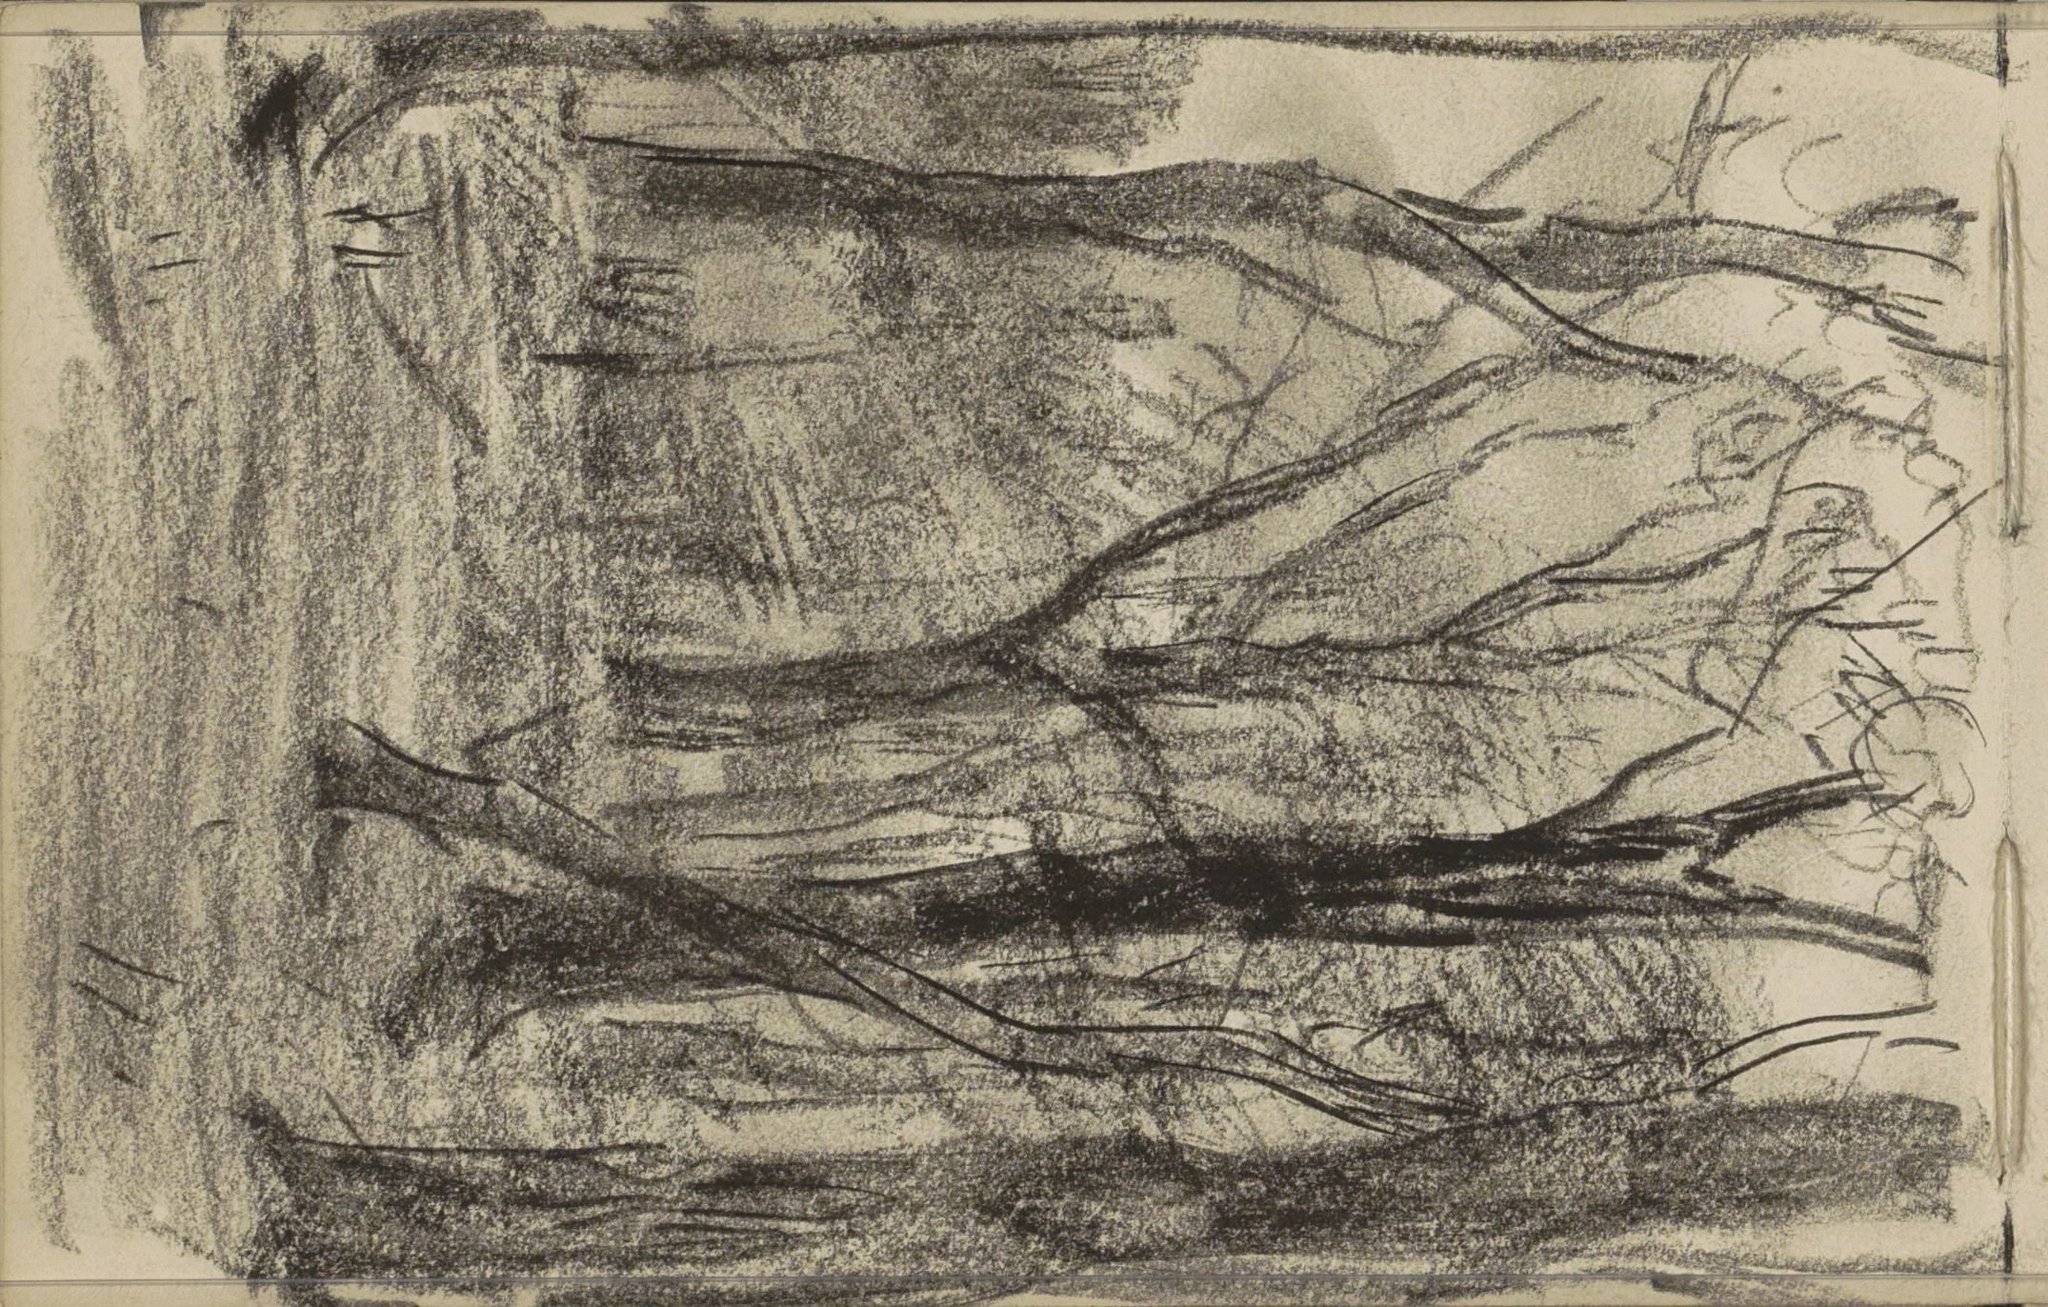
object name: sketchbook leaf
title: Bosgezicht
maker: johan antonie de jonge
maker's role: draughtsman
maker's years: 1864-1927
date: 1909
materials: chalk, paper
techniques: stumping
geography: south holland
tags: forest, wood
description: Bosgezicht. Blad 27 verso uit een schetsboek met 31 bladen.